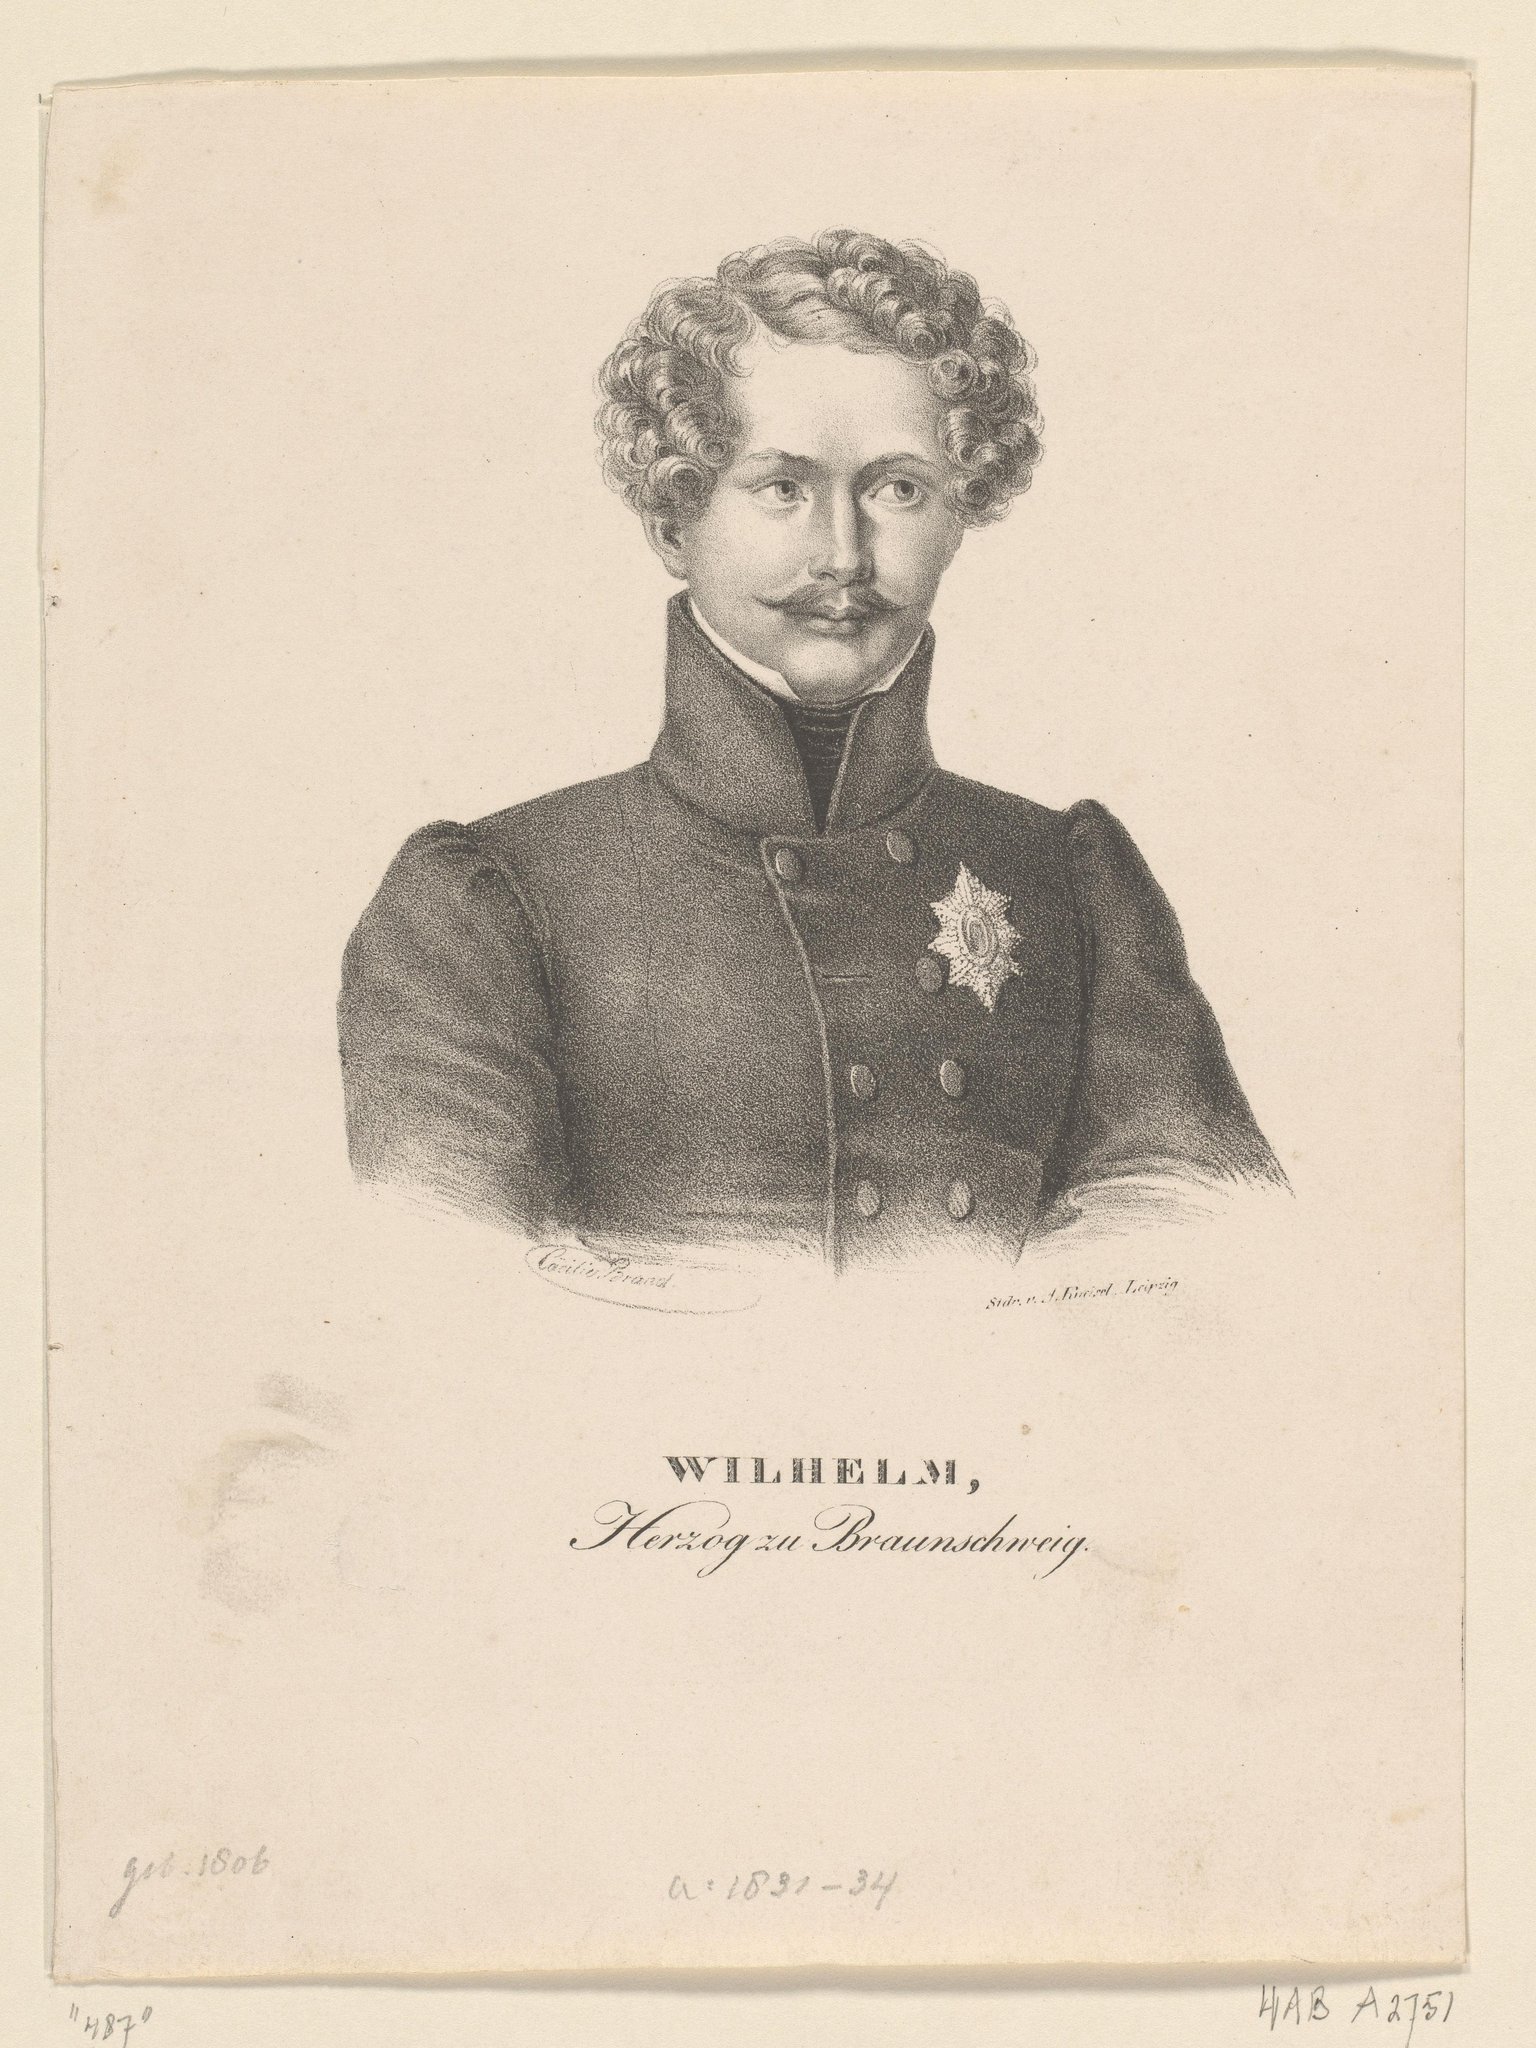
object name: print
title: Portret van Willem van Brunswijk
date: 1831-1852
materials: paper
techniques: lithograph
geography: leipzig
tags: willem van brunswijk, historical persons, ranks ~ rulers, sovereigns